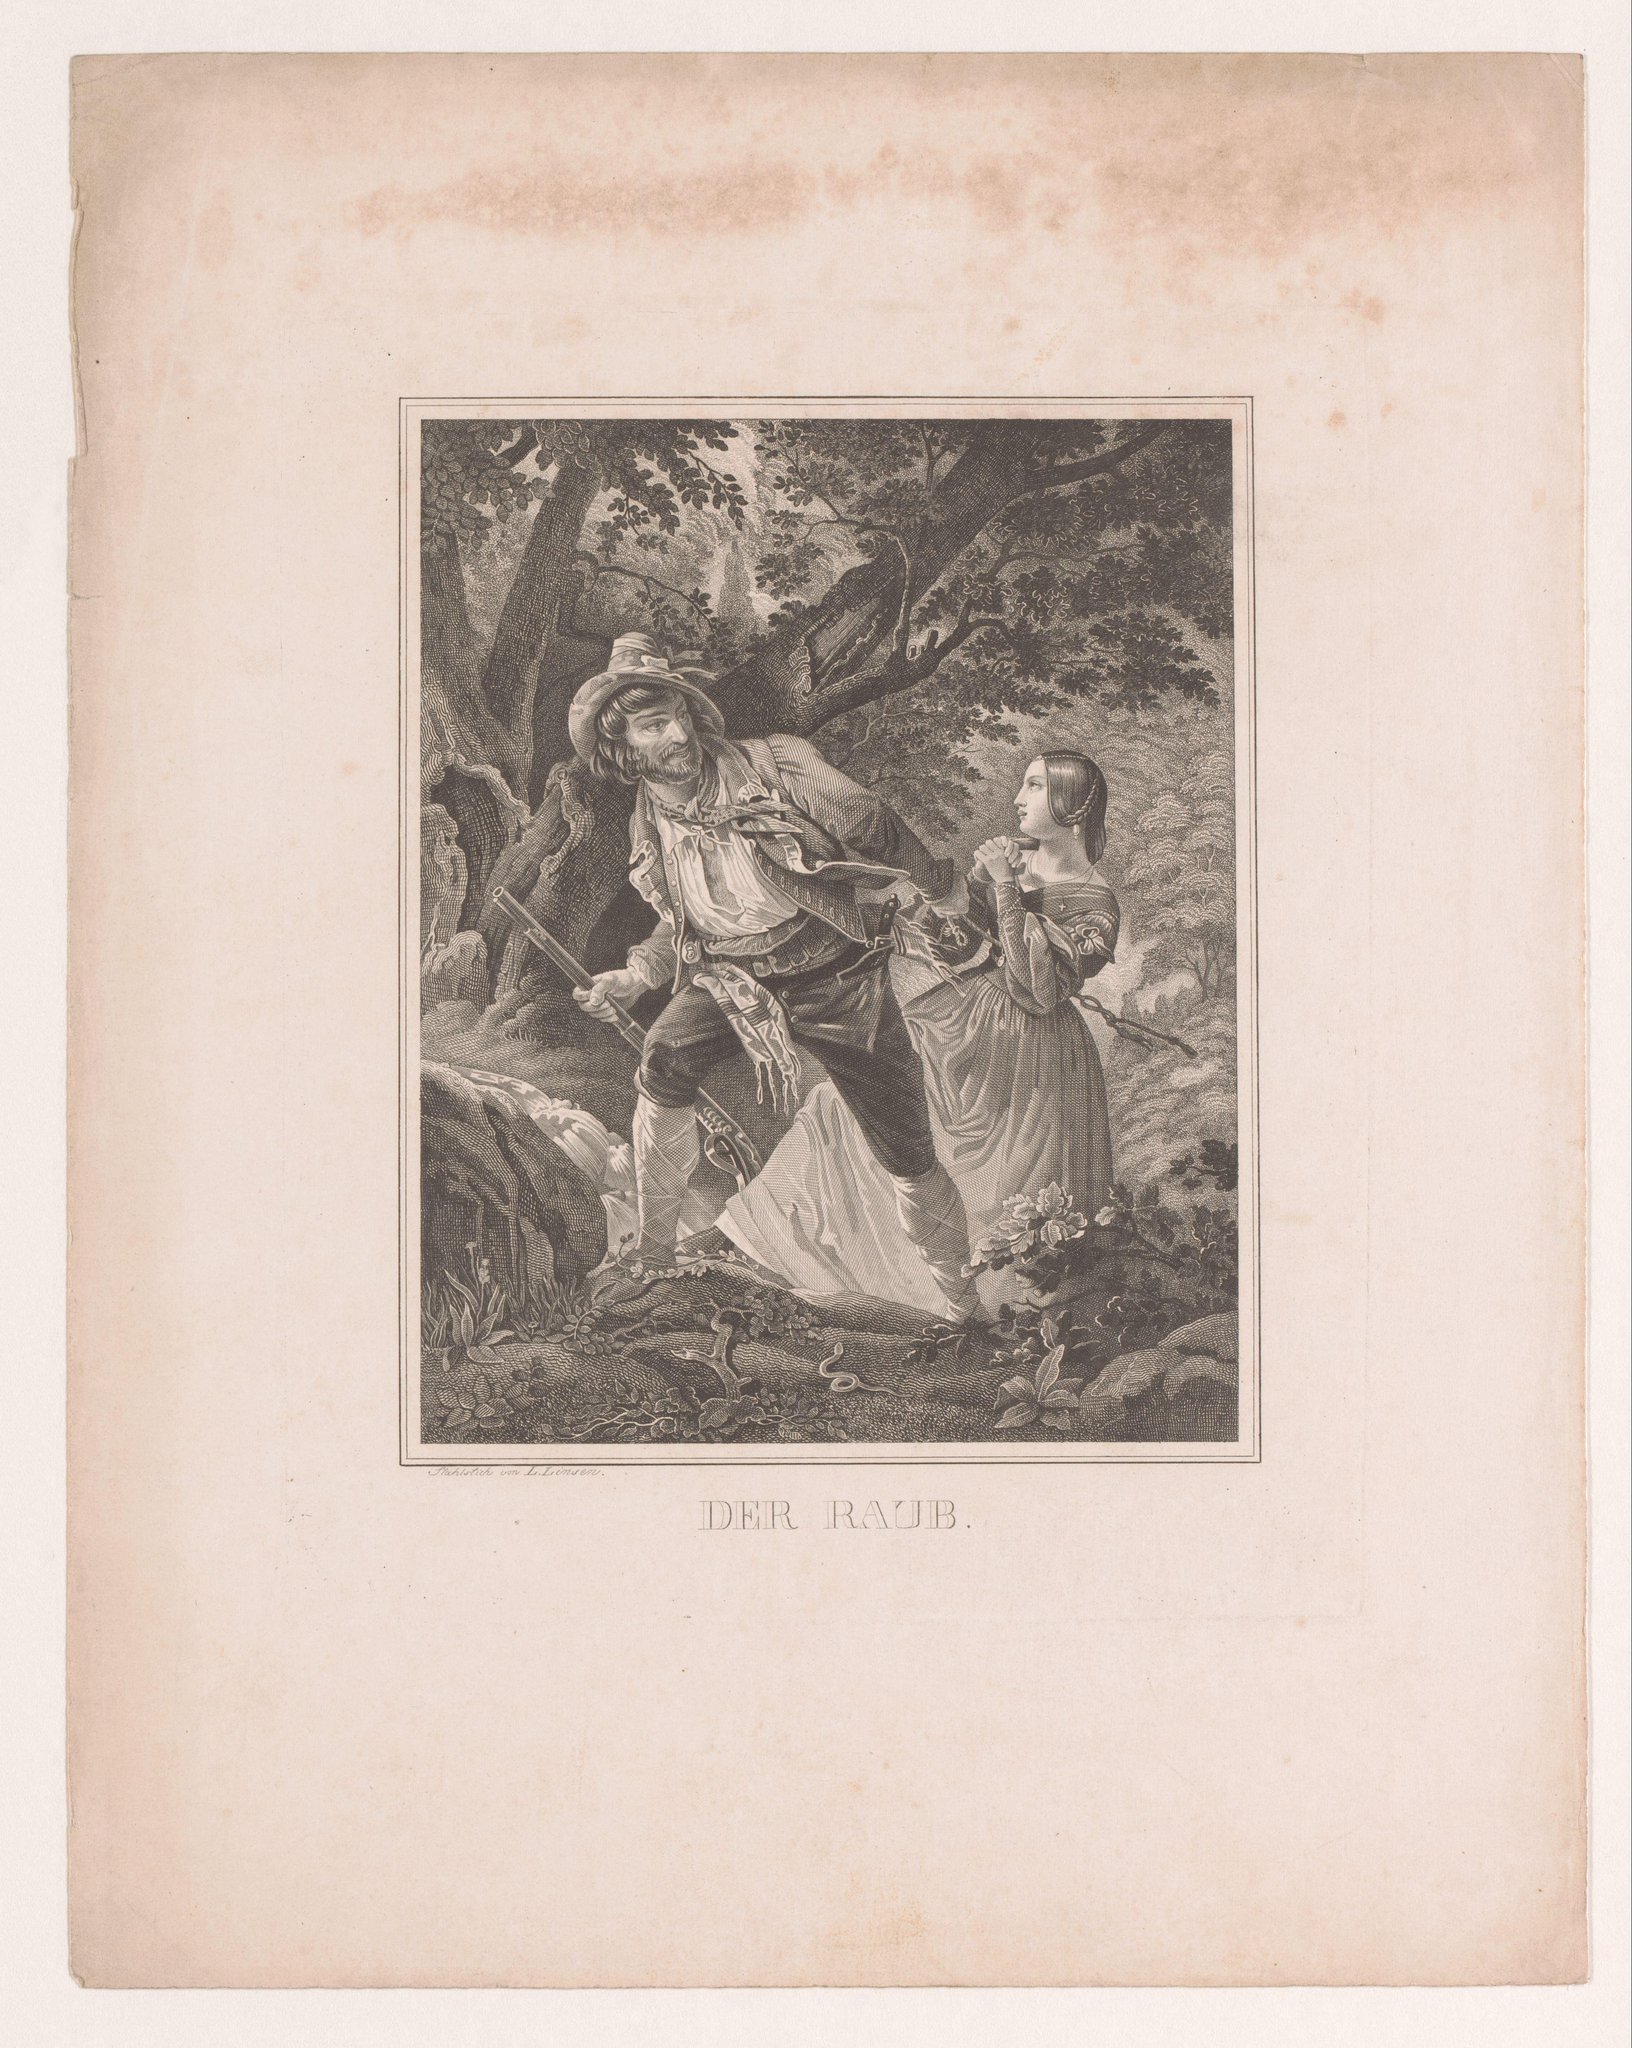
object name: print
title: Der Raub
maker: l. linsen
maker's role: print maker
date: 1839-1856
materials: paper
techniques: engraving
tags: kidnapping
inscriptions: collector's mark: Lugt 2228